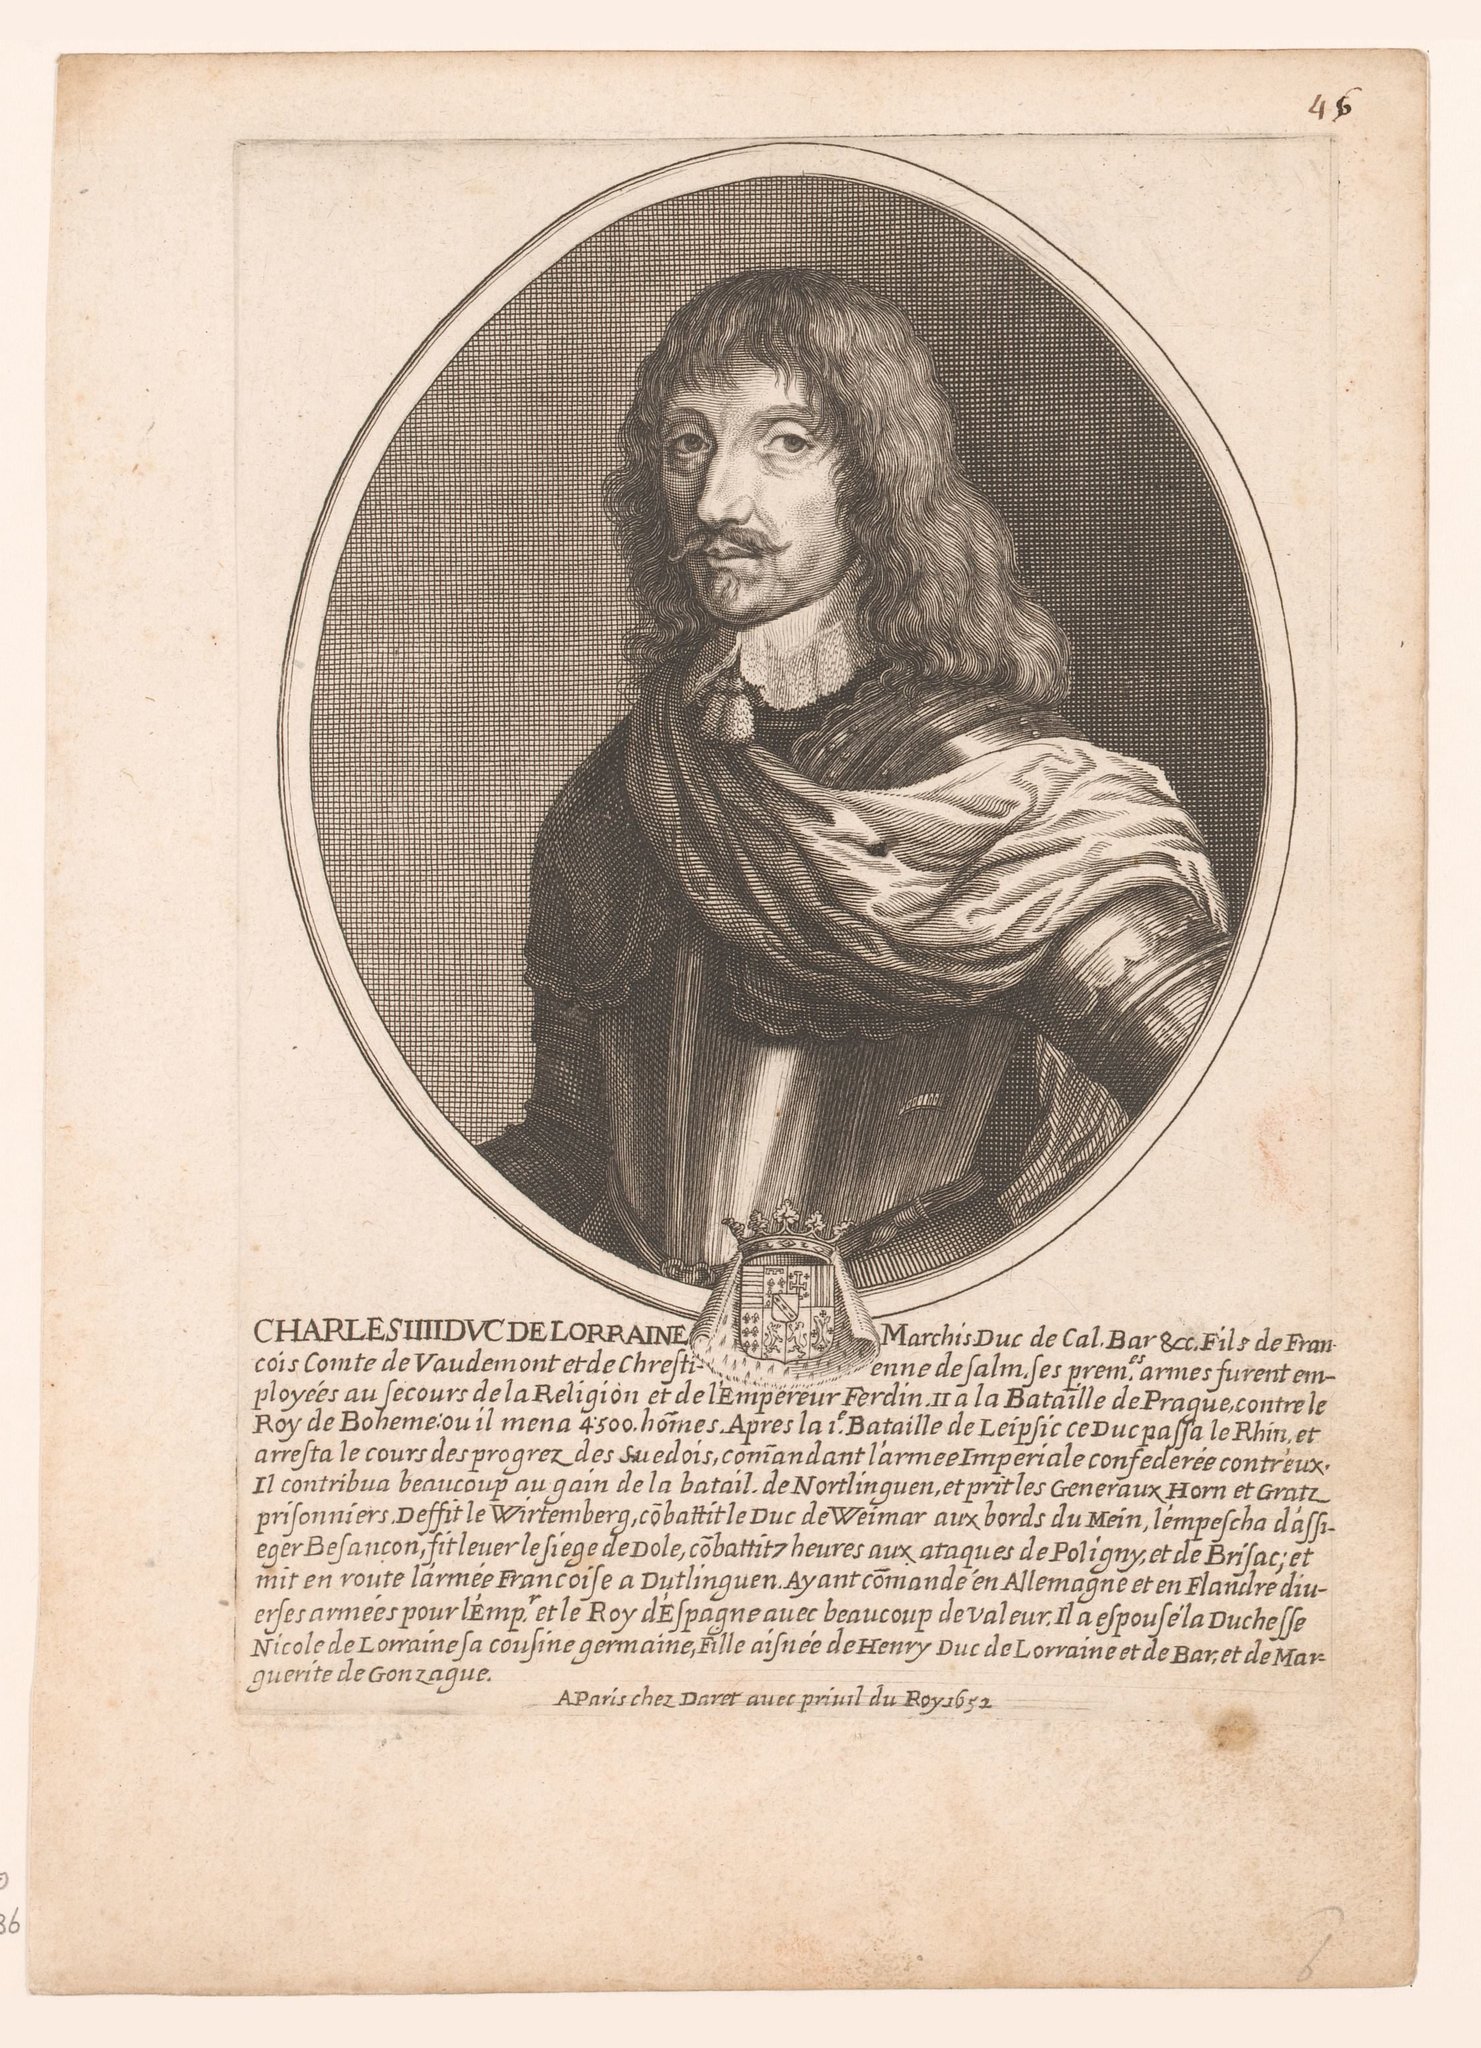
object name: print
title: Portretten van bekende historische figuren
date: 1652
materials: paper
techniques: engraving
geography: france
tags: karel iv hertog van lotharingen, historical persons, armorial bearing, heraldry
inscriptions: number: ‘46.’, collector's mark: Lugt 2228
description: Maakt deel uit van een serie portretten getiteld 'Tableaux historiques ou sont gravez les Illustres François et Etrangiers de l'un et l'autre sexe (...)', voor het eerst uitgegeven in 1652 door Daret. Een tweede staat werd uitgegeven door Boissevin en een derde door Jollain.